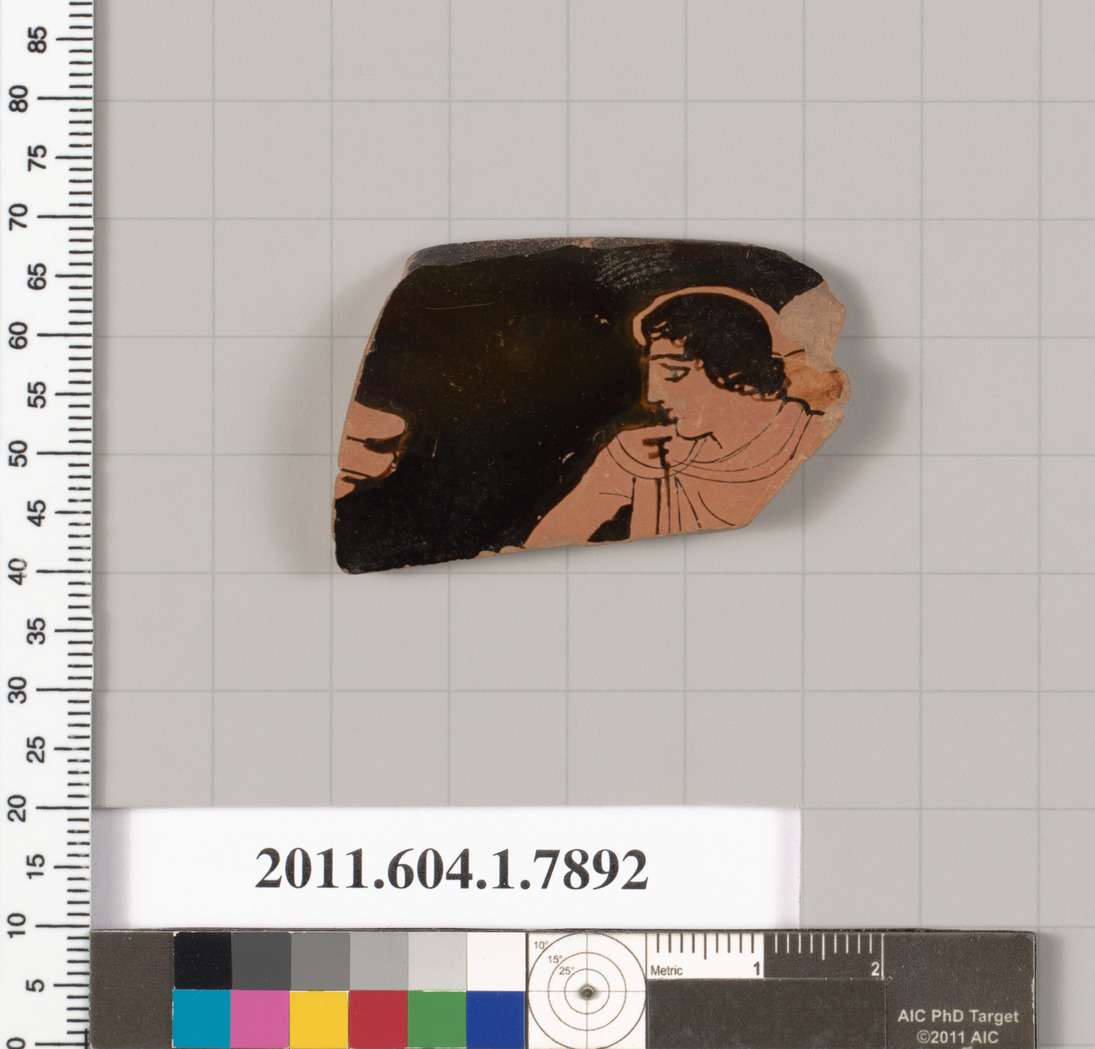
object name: kylix fragment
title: Terracotta rim fragment of a kylix (drinking cup)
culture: greek, attic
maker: painter of london e 777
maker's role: artist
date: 450 BCE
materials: terracotta